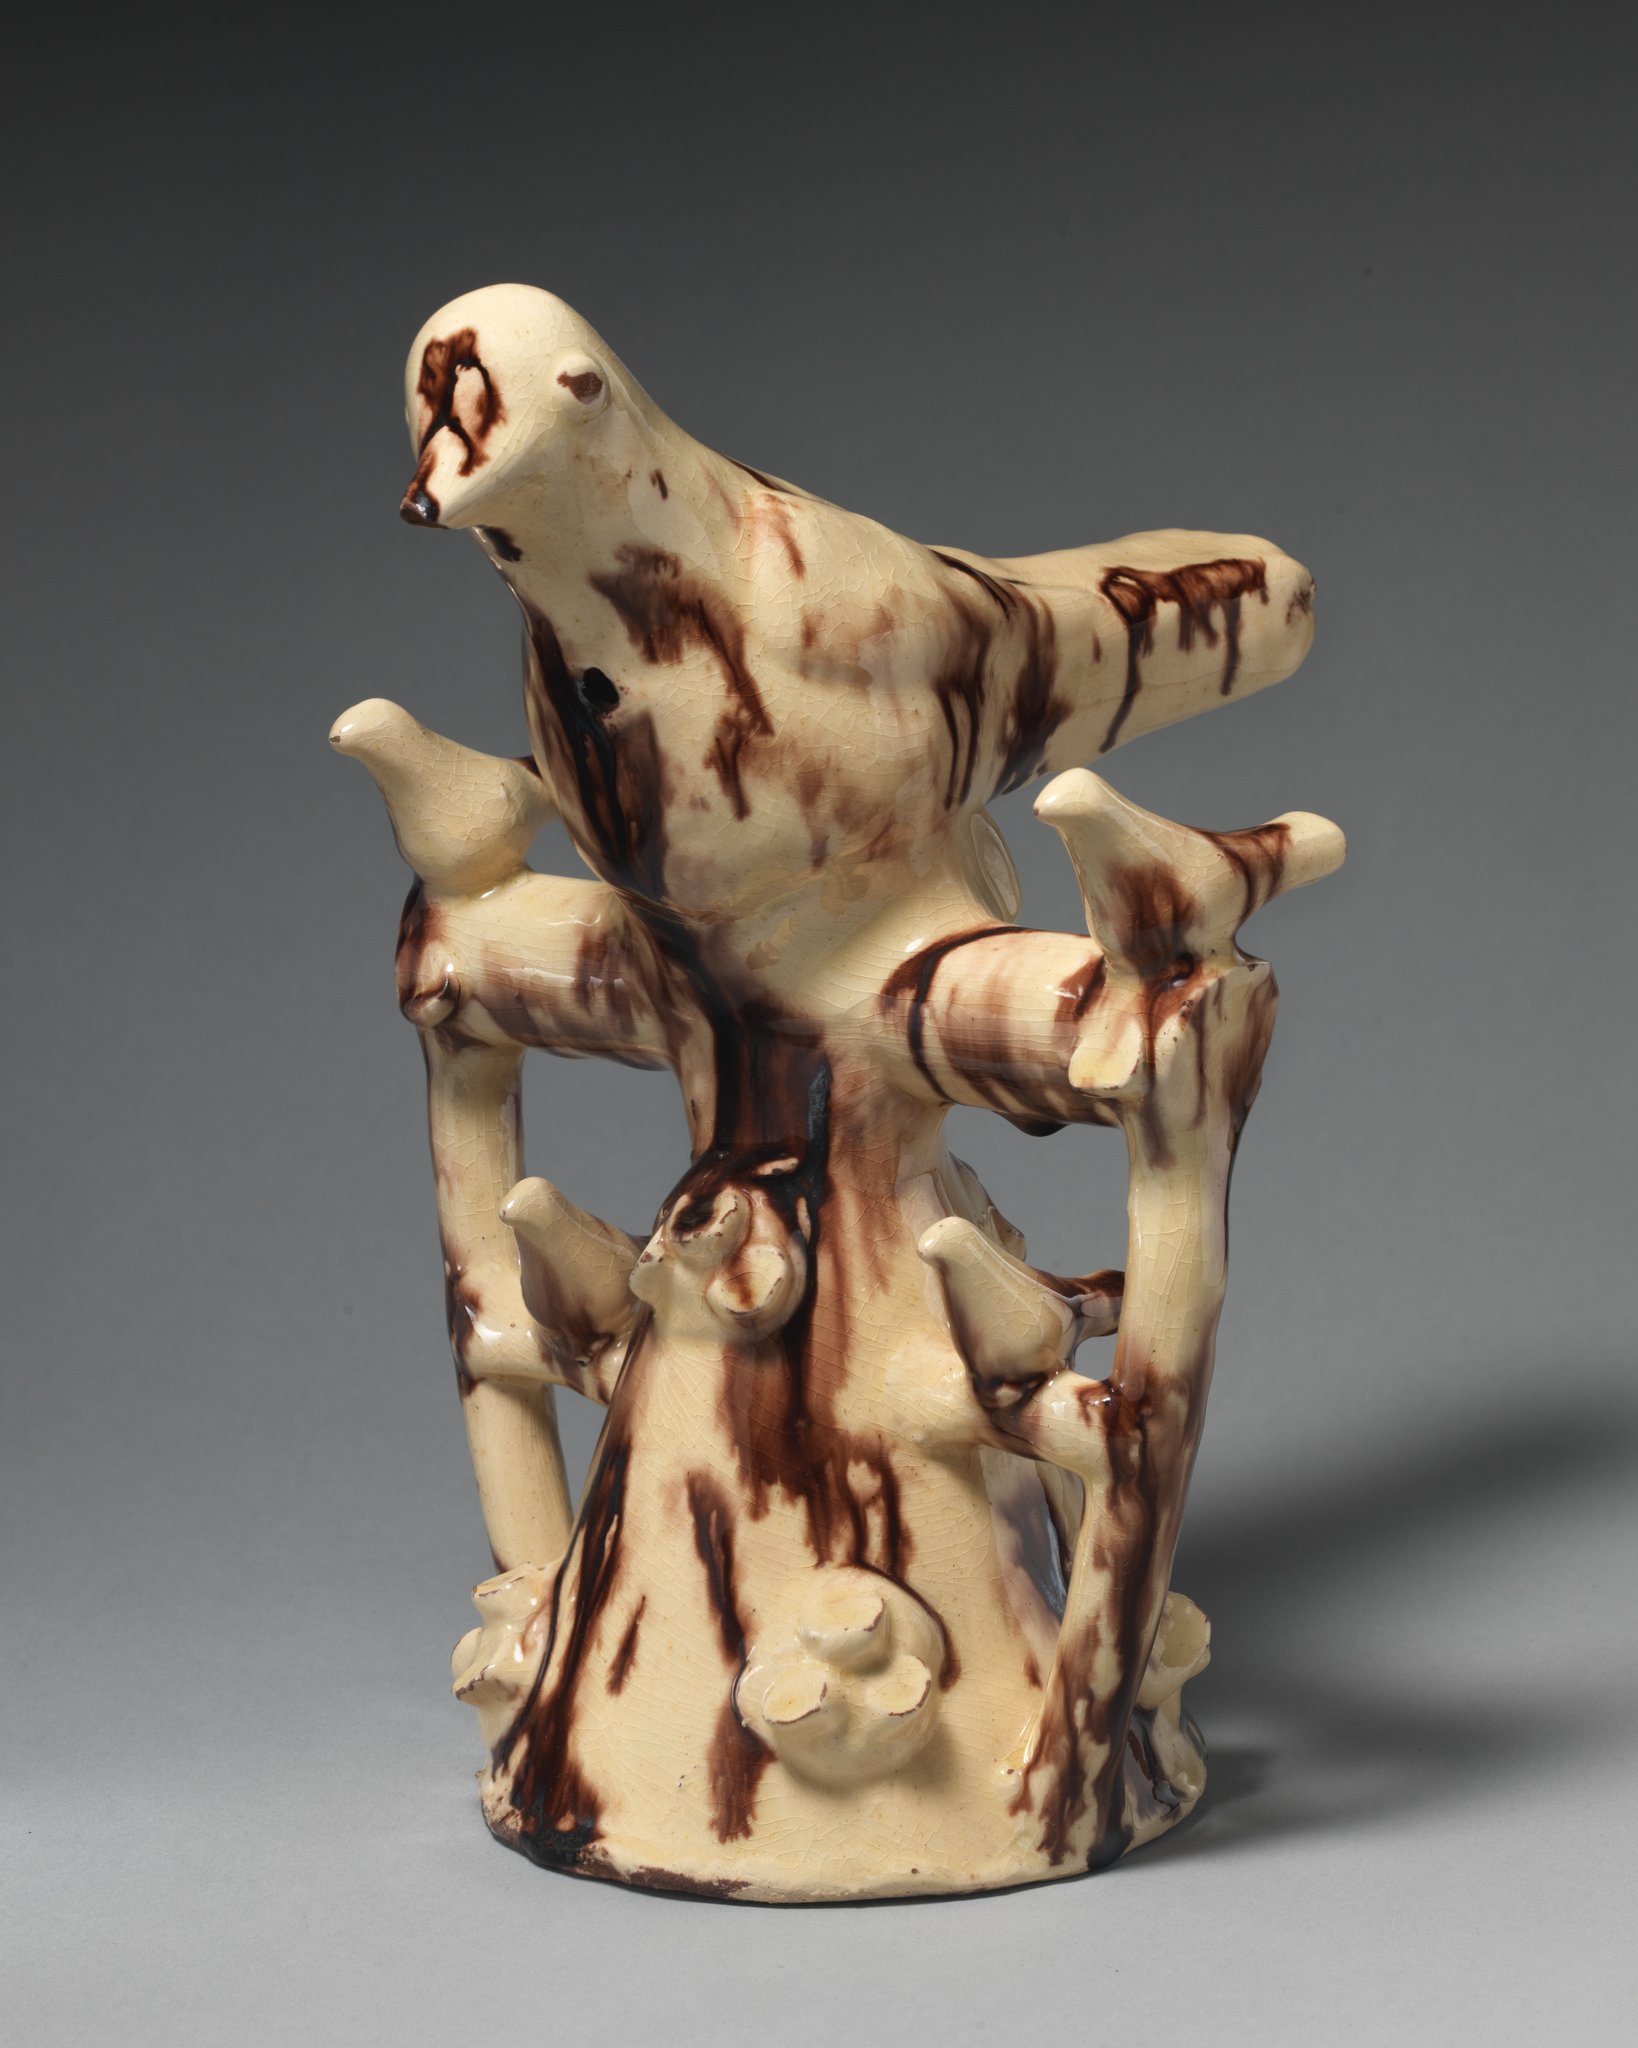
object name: whistle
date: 1790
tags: birds